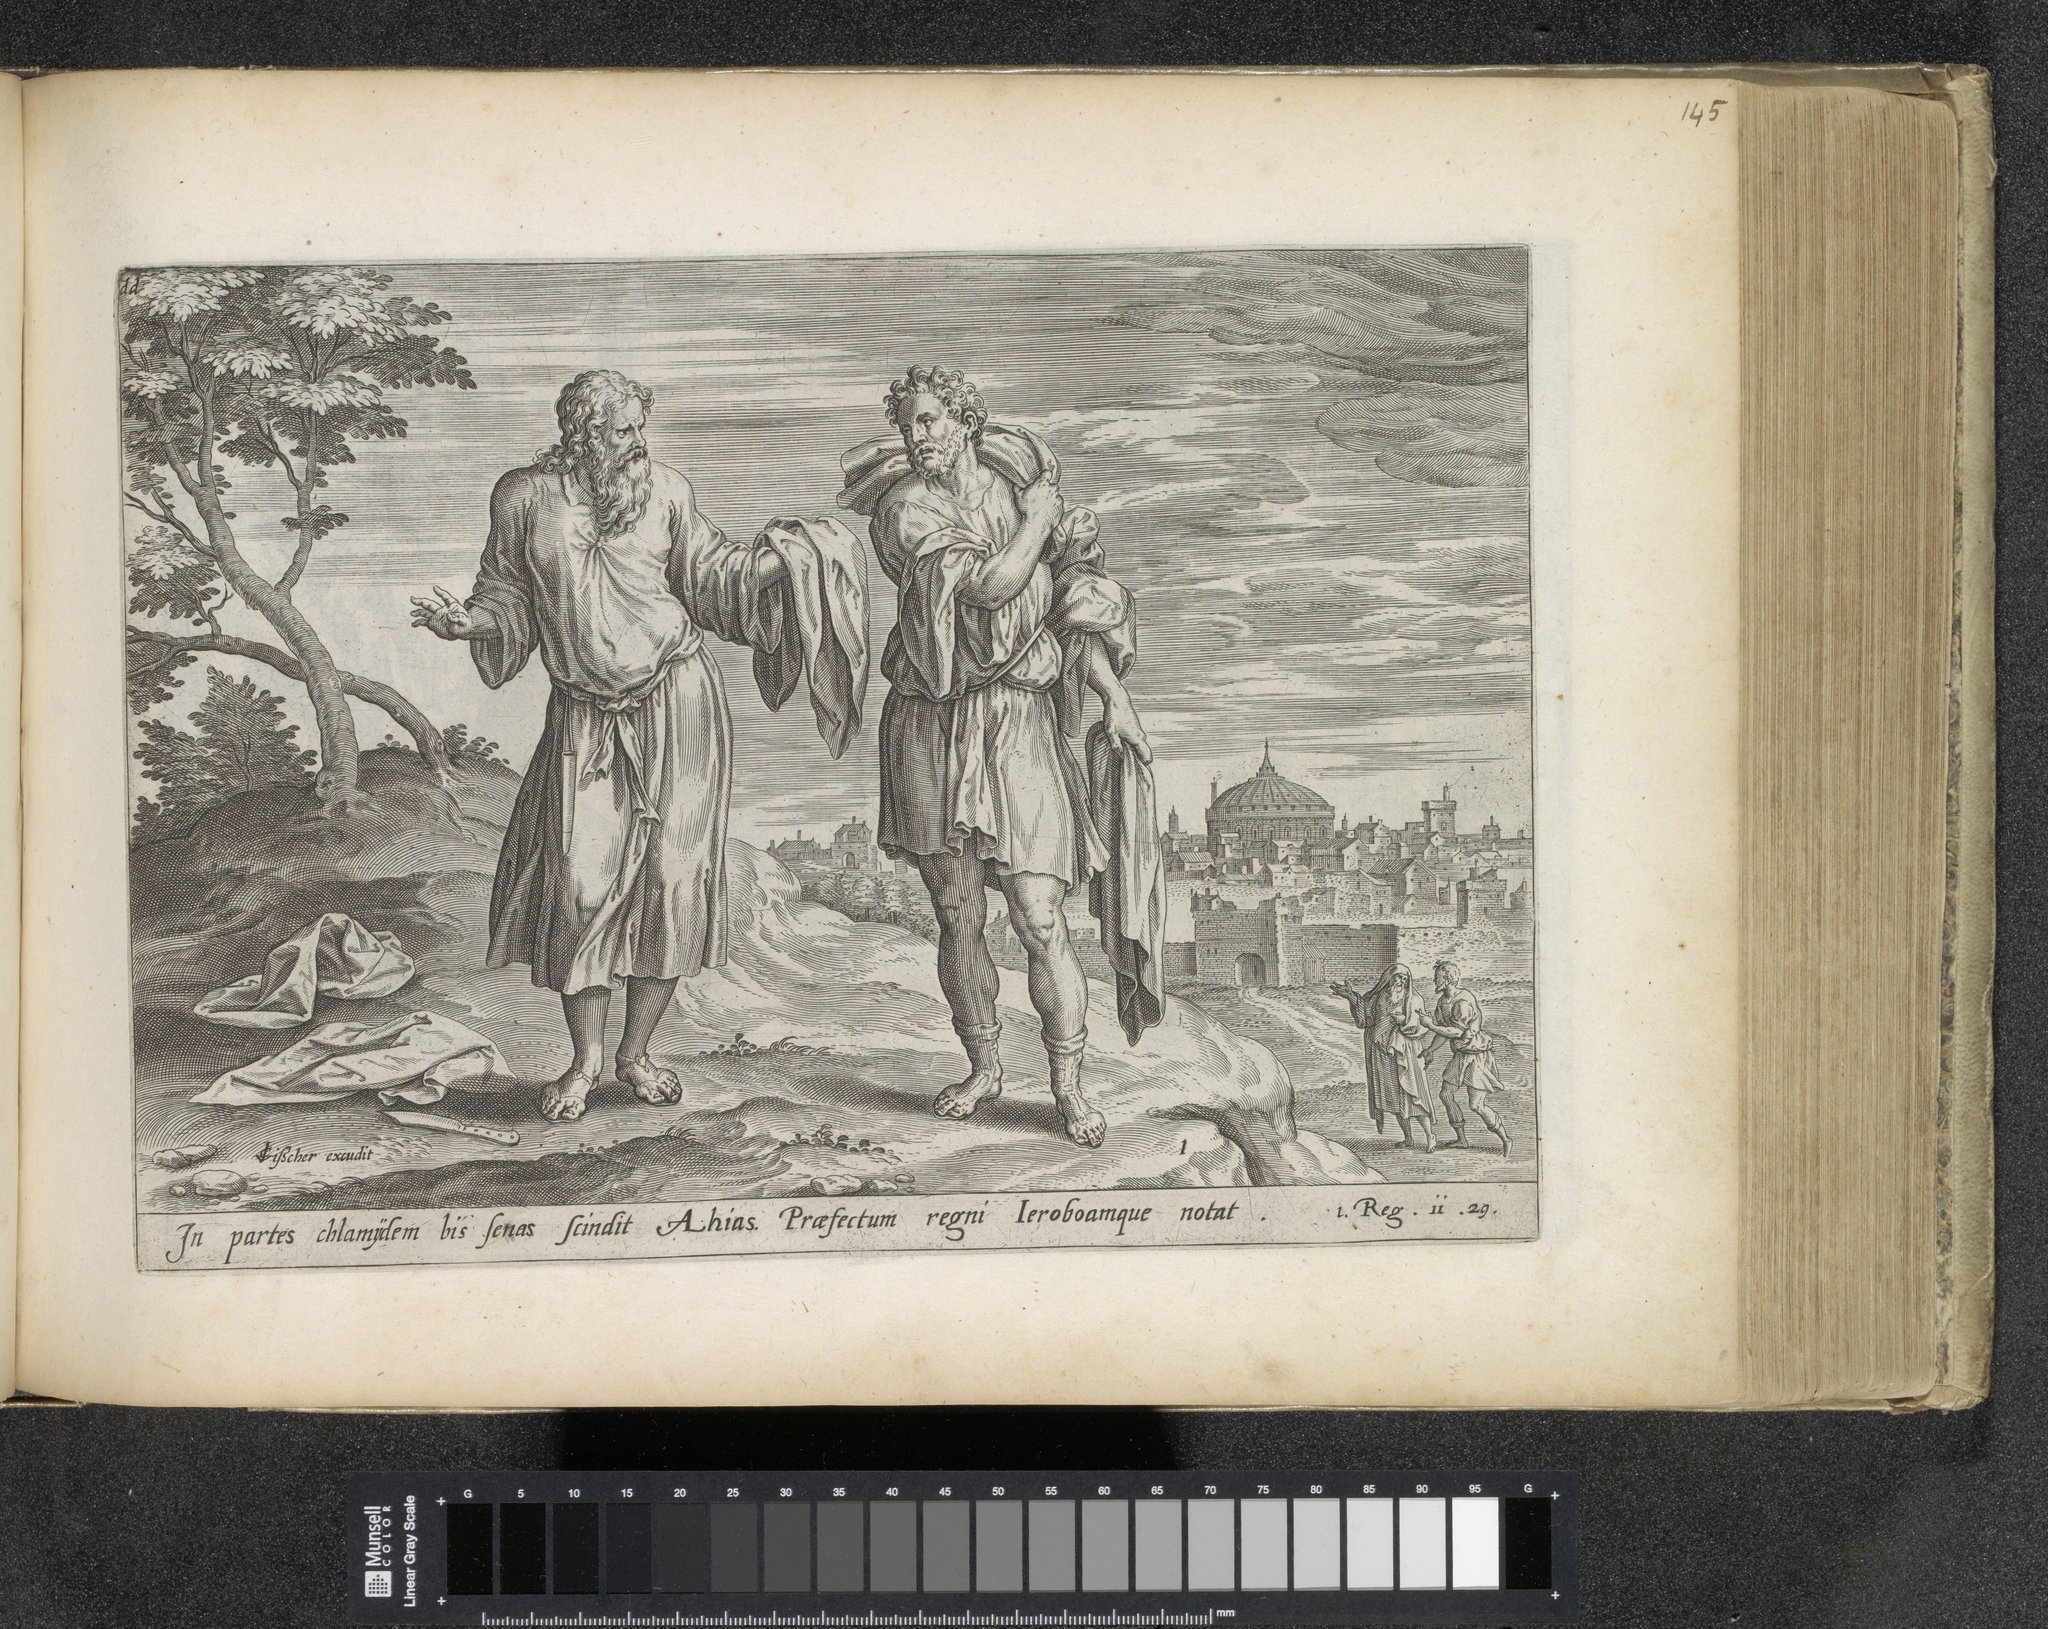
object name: album leaf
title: Jerobeam en de profeet Achia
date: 1579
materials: paper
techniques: engraving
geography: amsterdam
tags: meeting of jeroboam and the prophet ahijah; ahijah rends his garment in twelve pieces, ten of which he gives to jeroboam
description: De profeet Achia heeft zijn mantel in twaalf stukken gescheurd en overhandigt tien stukken aan Jerobeam. De gescheurde mantel staat symbool voor de splitsing van het Joodse volk. Jerobeam werd koning van tien van de twaalf stammen. Onder de voorstelling een verwijzing in het Latijn naar de Bijbeltekst in 1 Kon. 11:29. Deze prent maakt deel uit van een album.